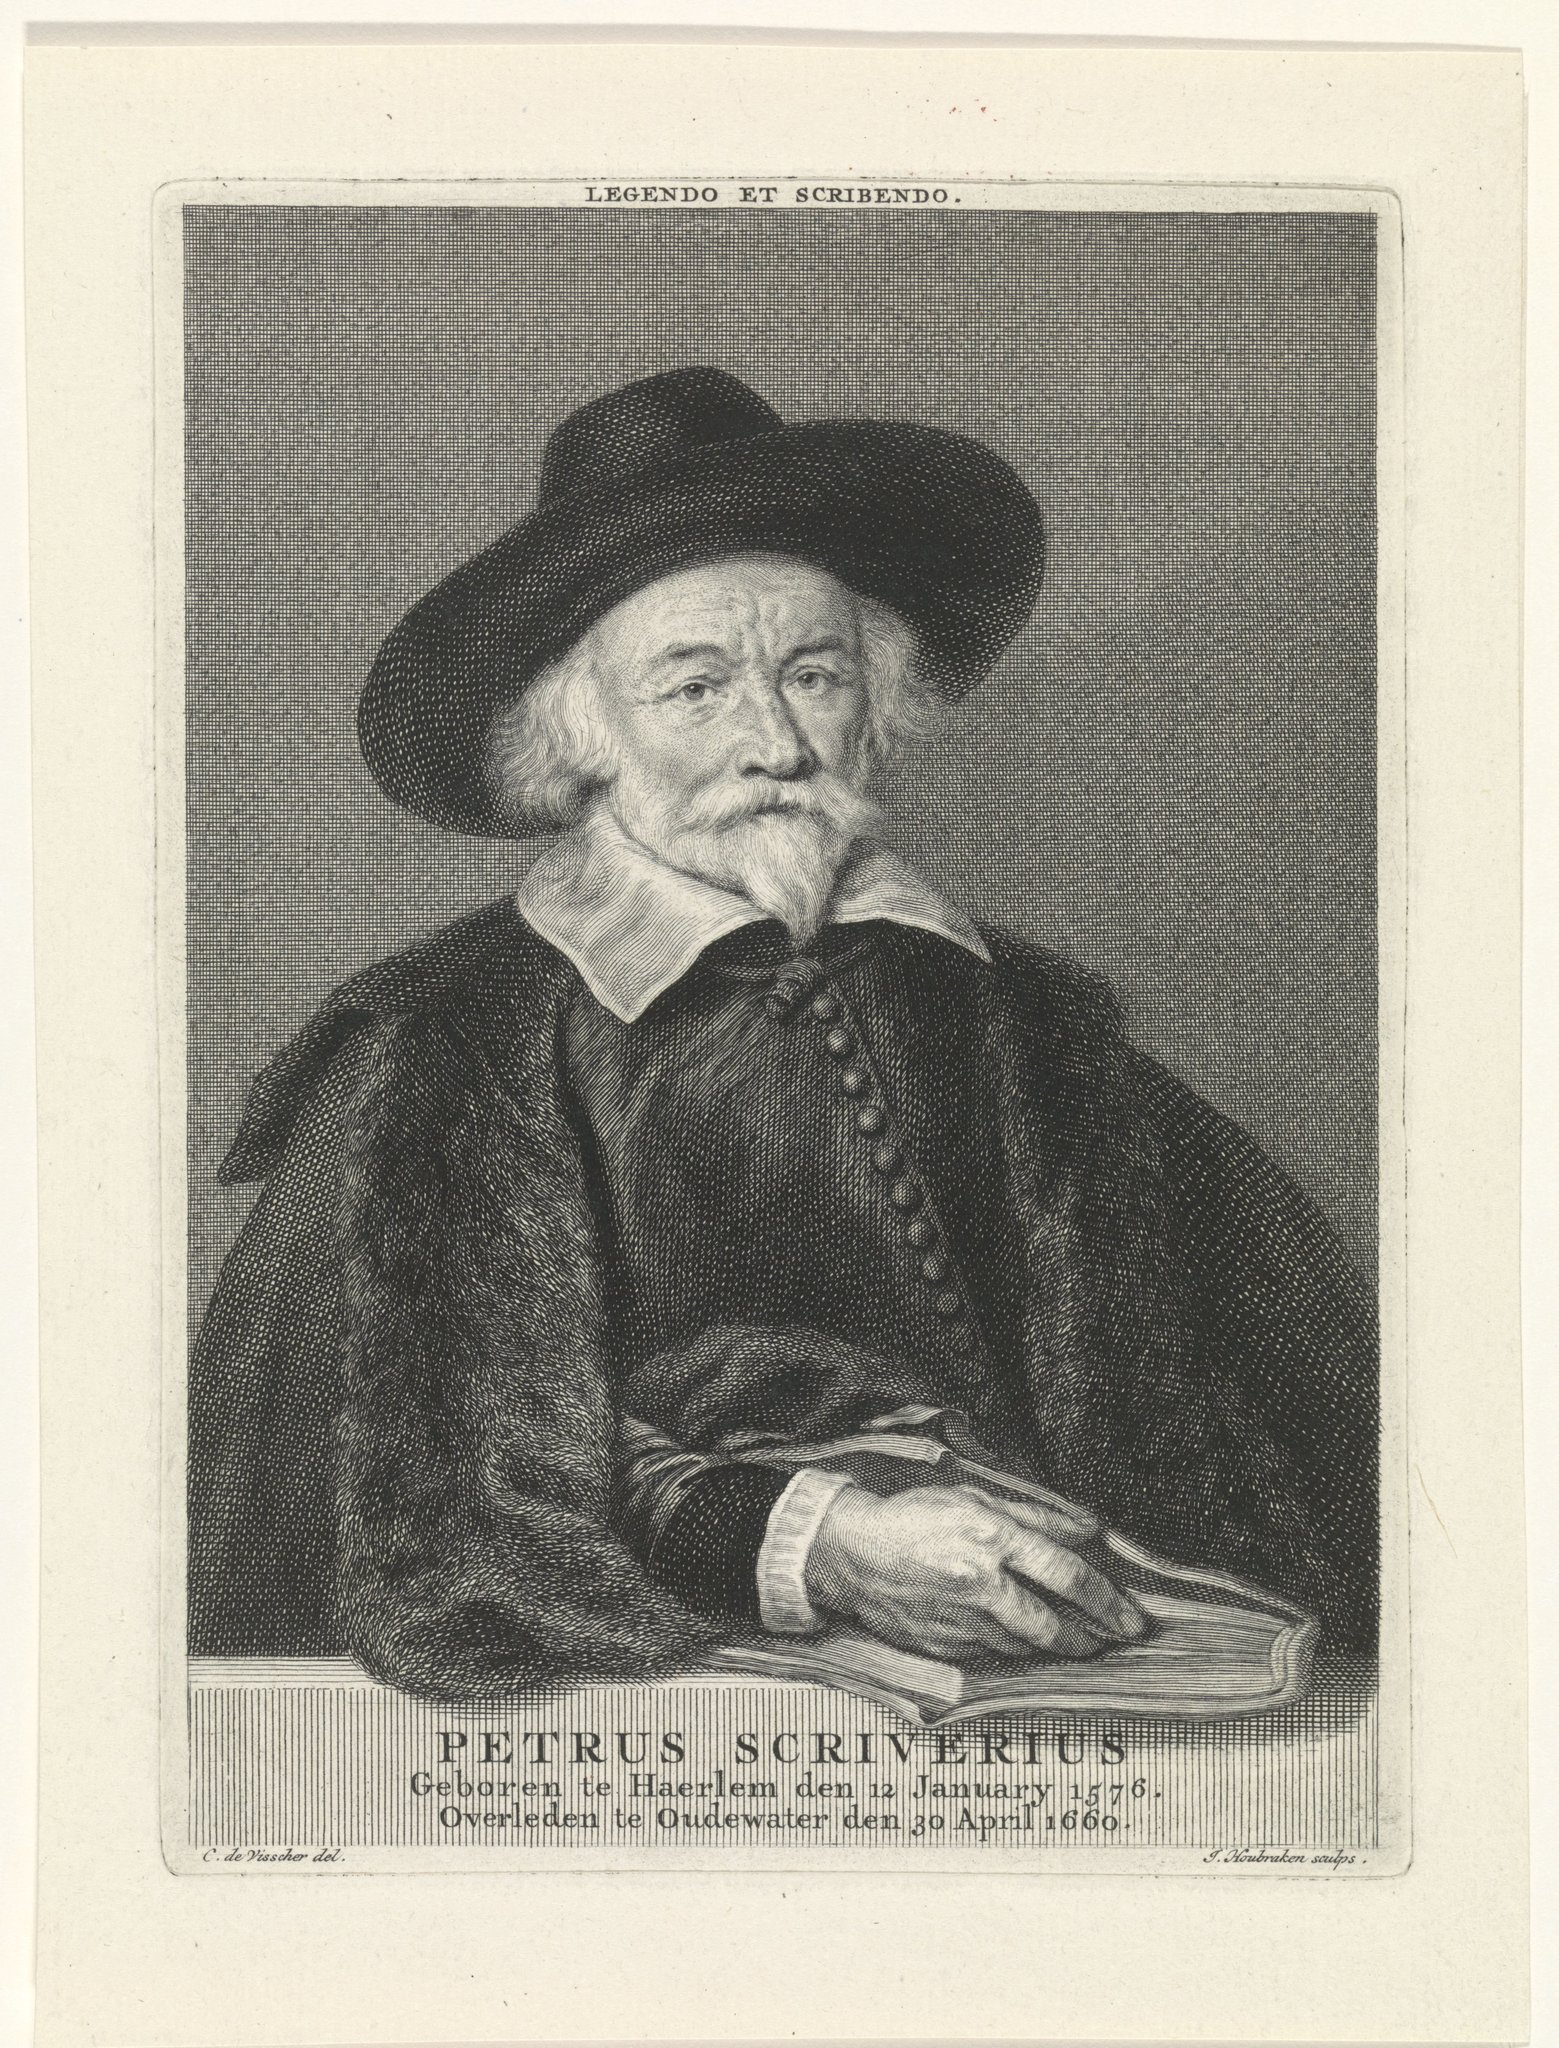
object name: print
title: Portret van Petrus Scriverius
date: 1708-1780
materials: paper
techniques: engraving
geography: amsterdam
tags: petrus scriverius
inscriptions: collector's mark: Lugt 240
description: Portret ten halven lijve naar rechts van Petrus Scriverius, zijn hand rustende op een boek op een plint voor hem. Bovenaan een regel in het Latijn en onderaan de naam en gegevens van de geportretteerde in drie regels in het Nederlands.